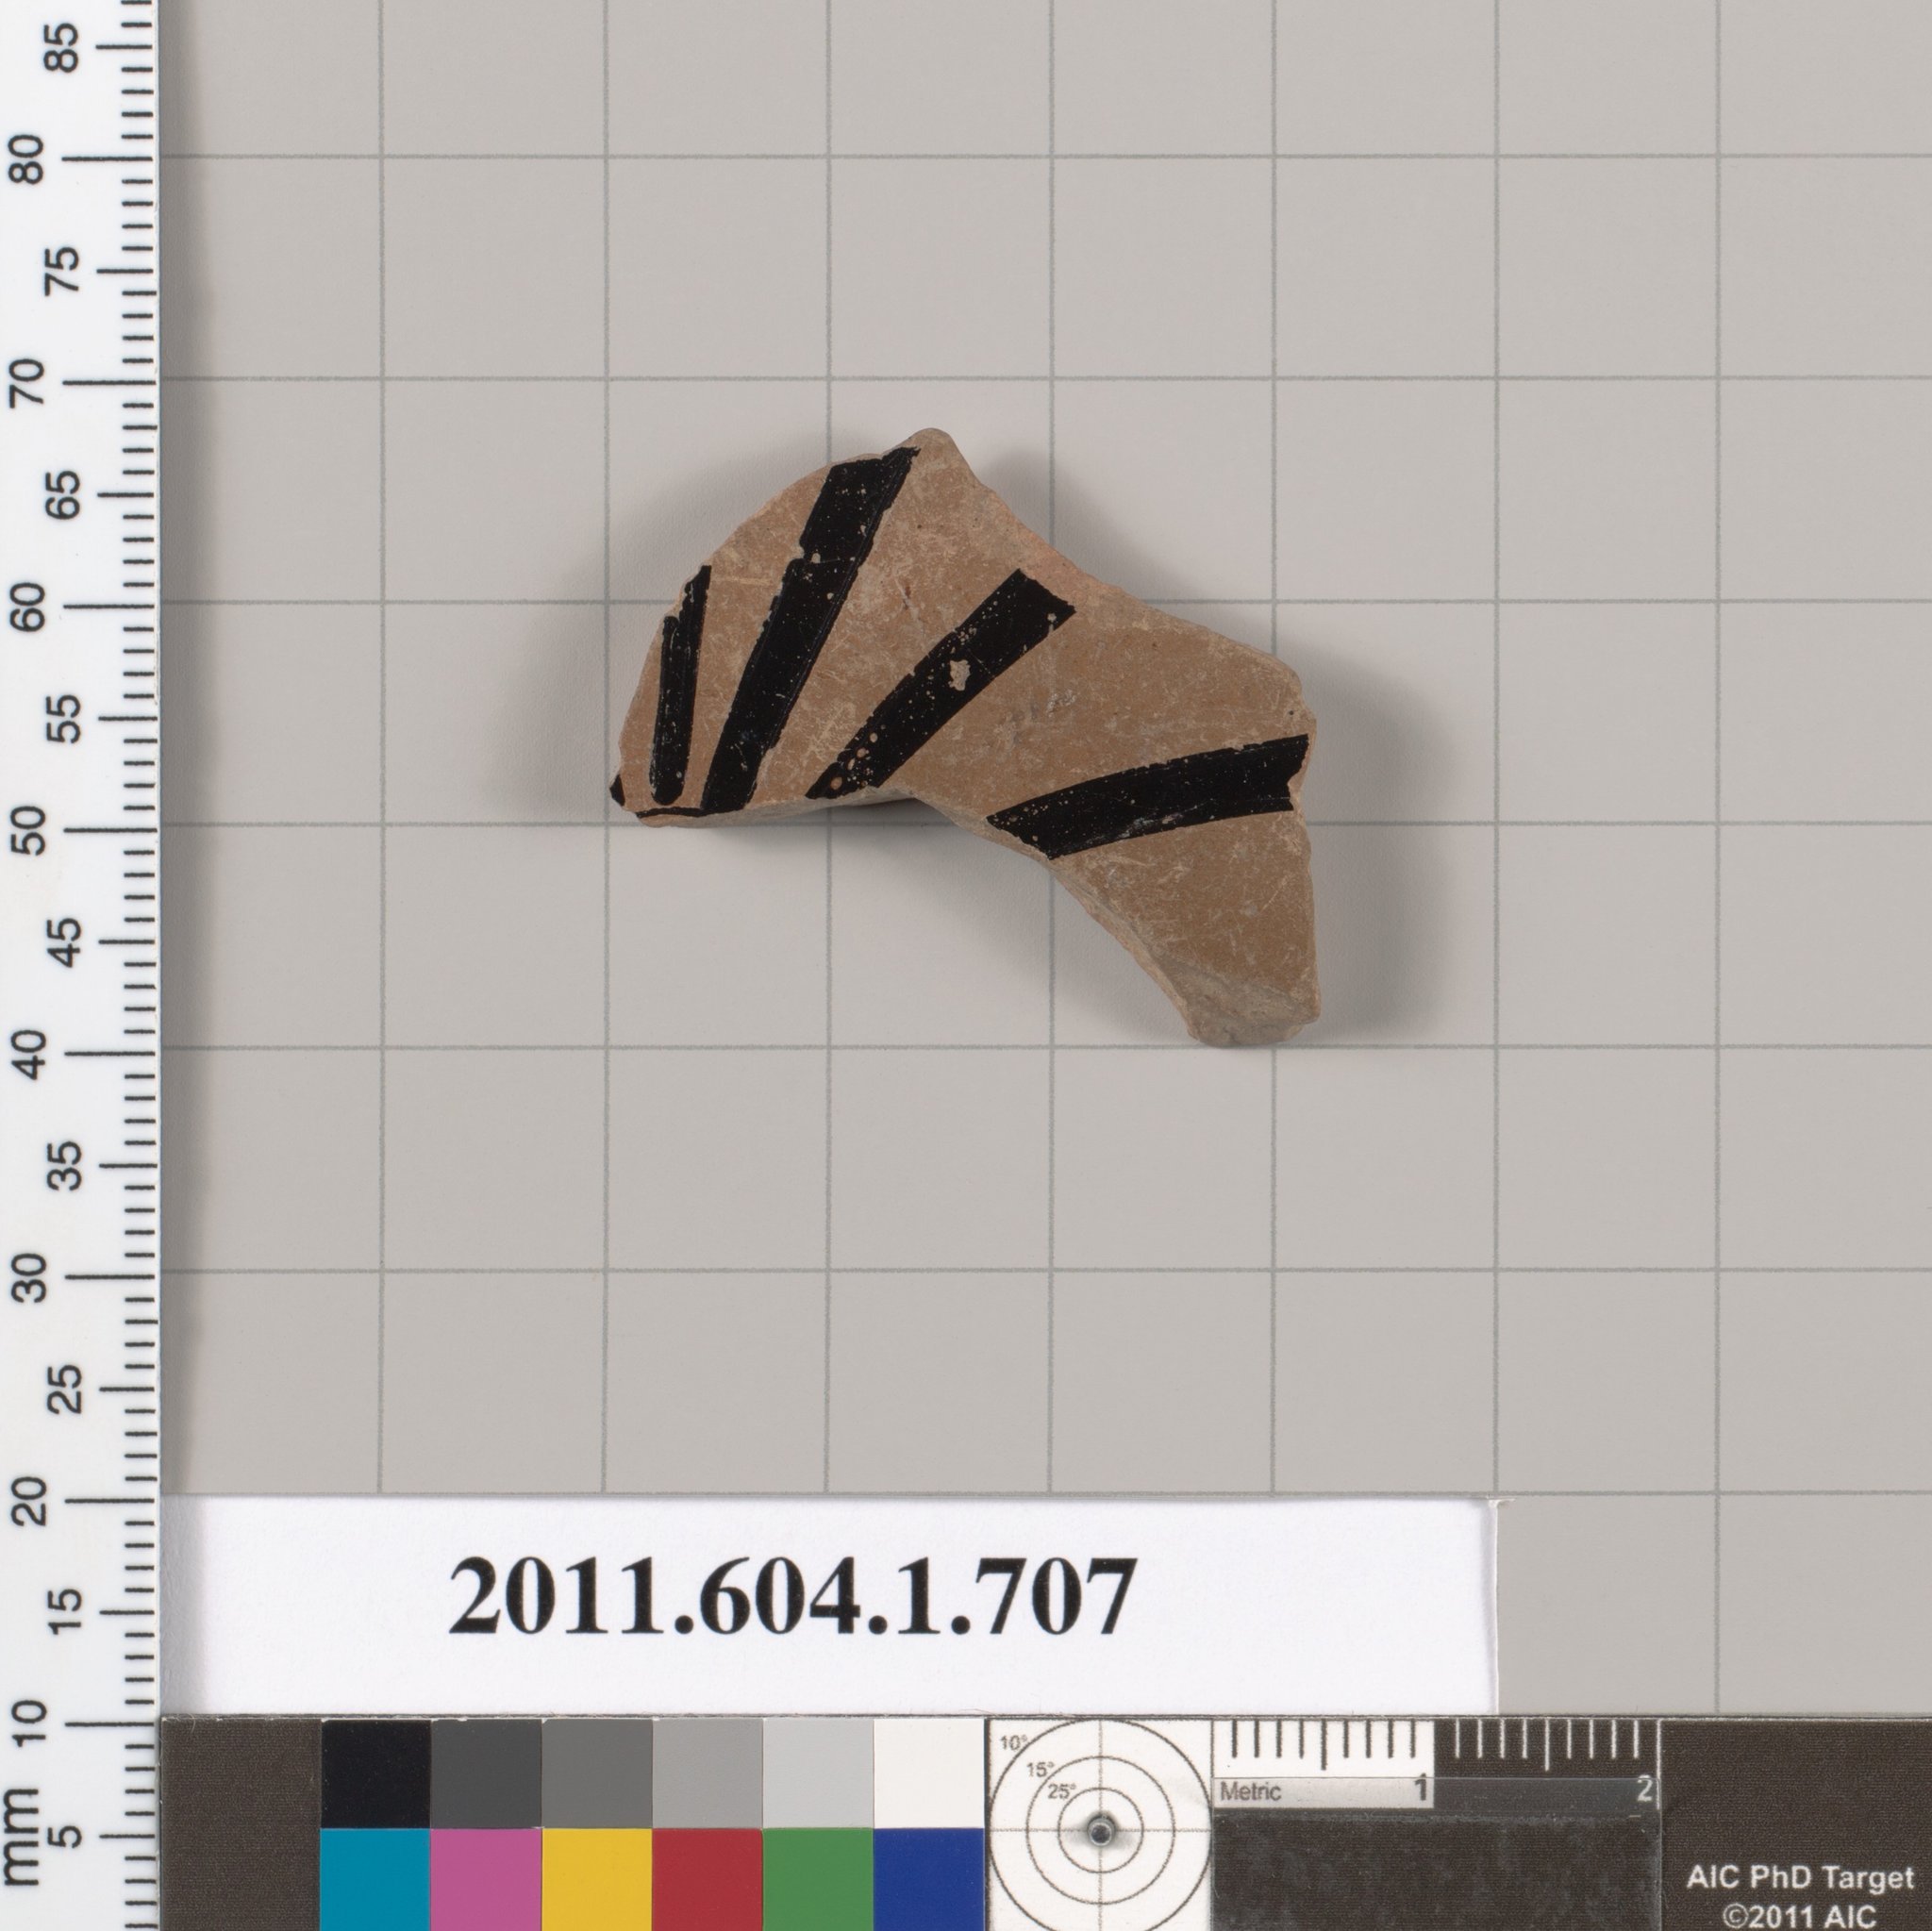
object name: kylix fragment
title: Terracotta fragment of a kylix (drinking cup)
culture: greek, attic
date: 520-500 BCE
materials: terracotta